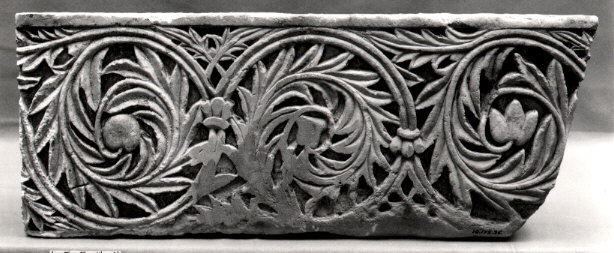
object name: fragment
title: Fragment of Frieze with Acanthus Leaves Encircling Fruit and Flowers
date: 501-600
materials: limestone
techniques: carving, relief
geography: egypt